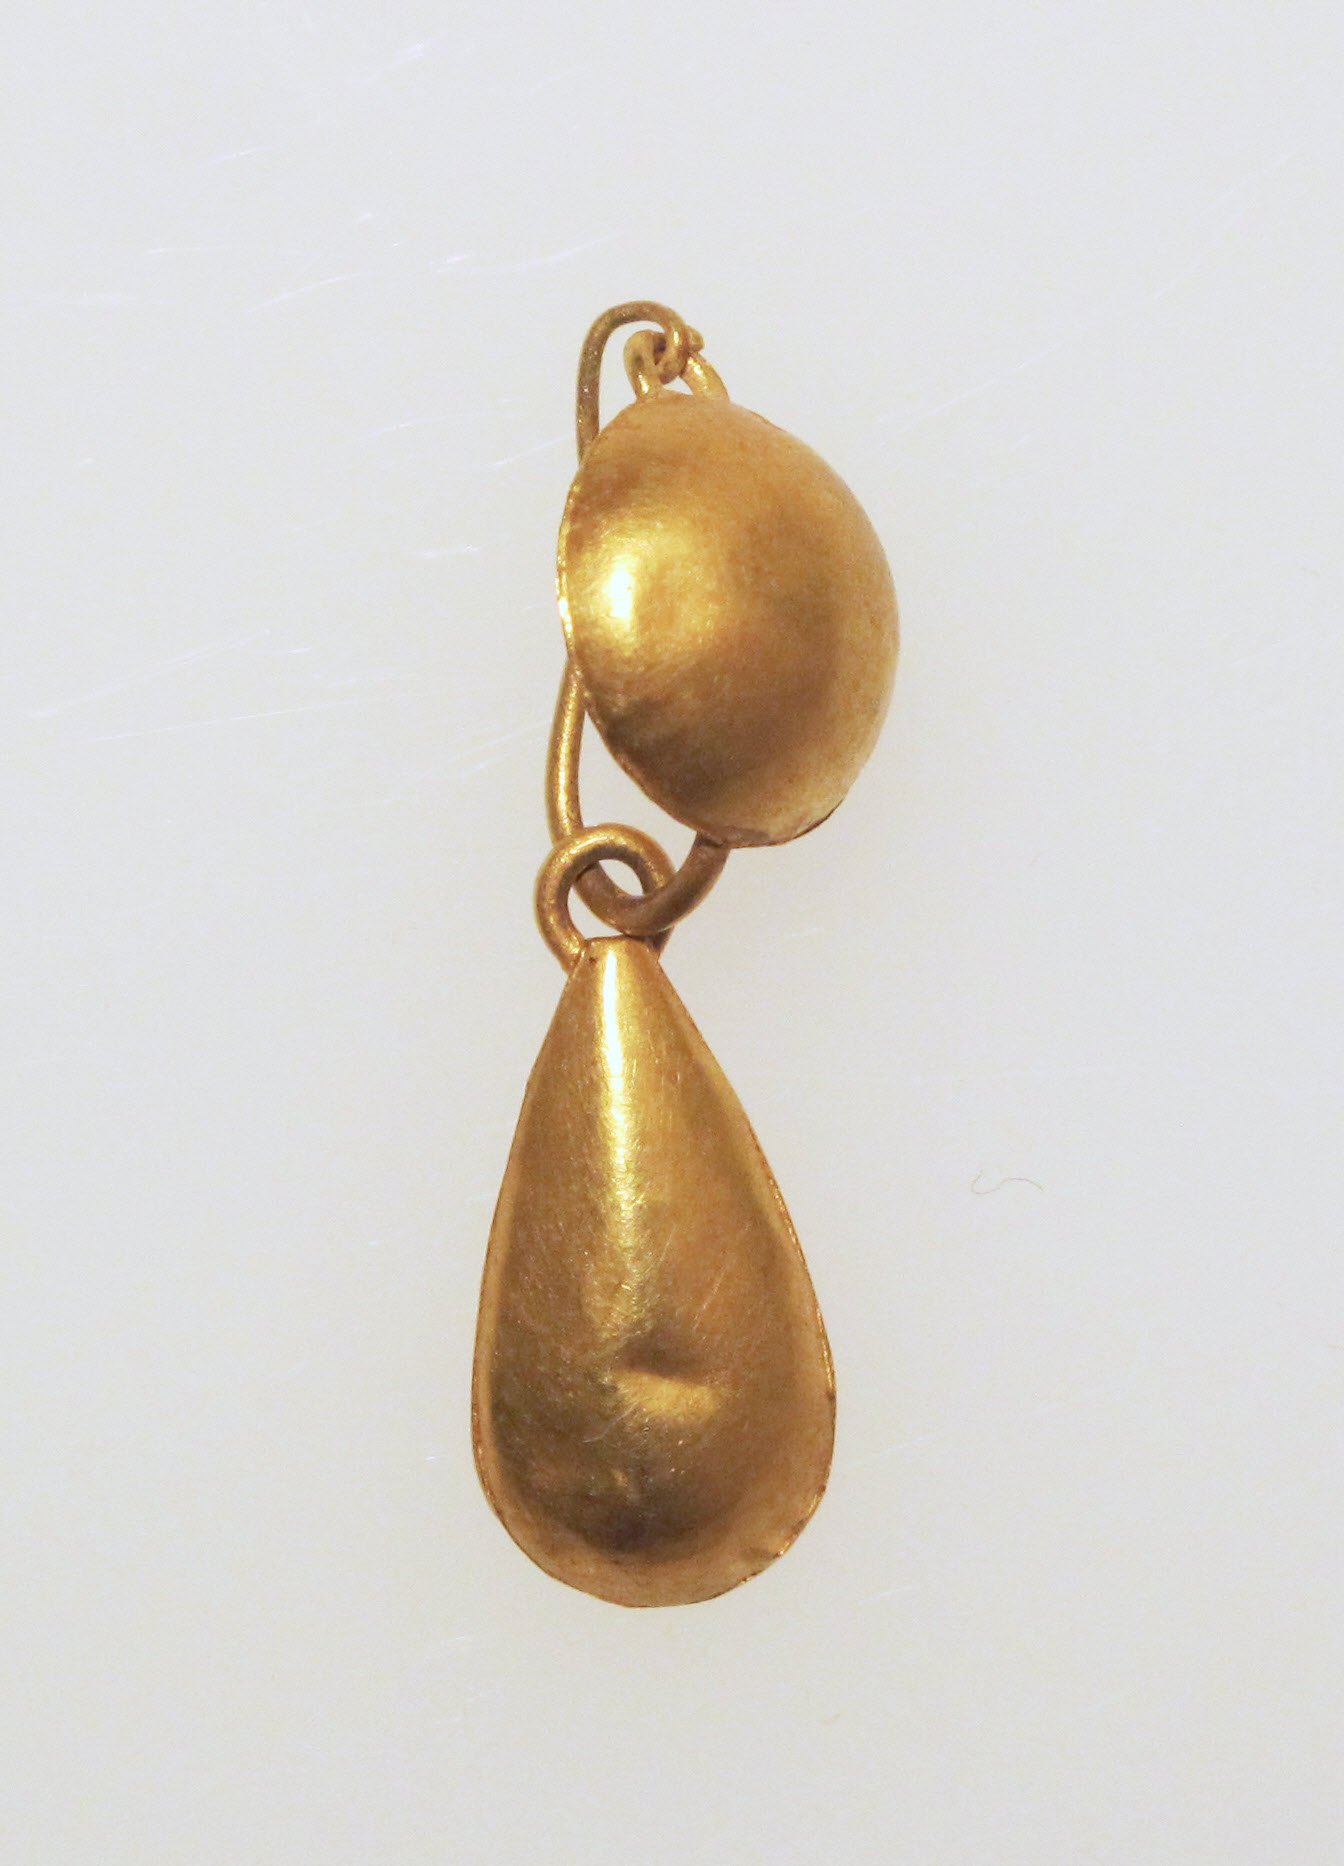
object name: earring with pendant and disc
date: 7000 BCE-330 CE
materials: gold